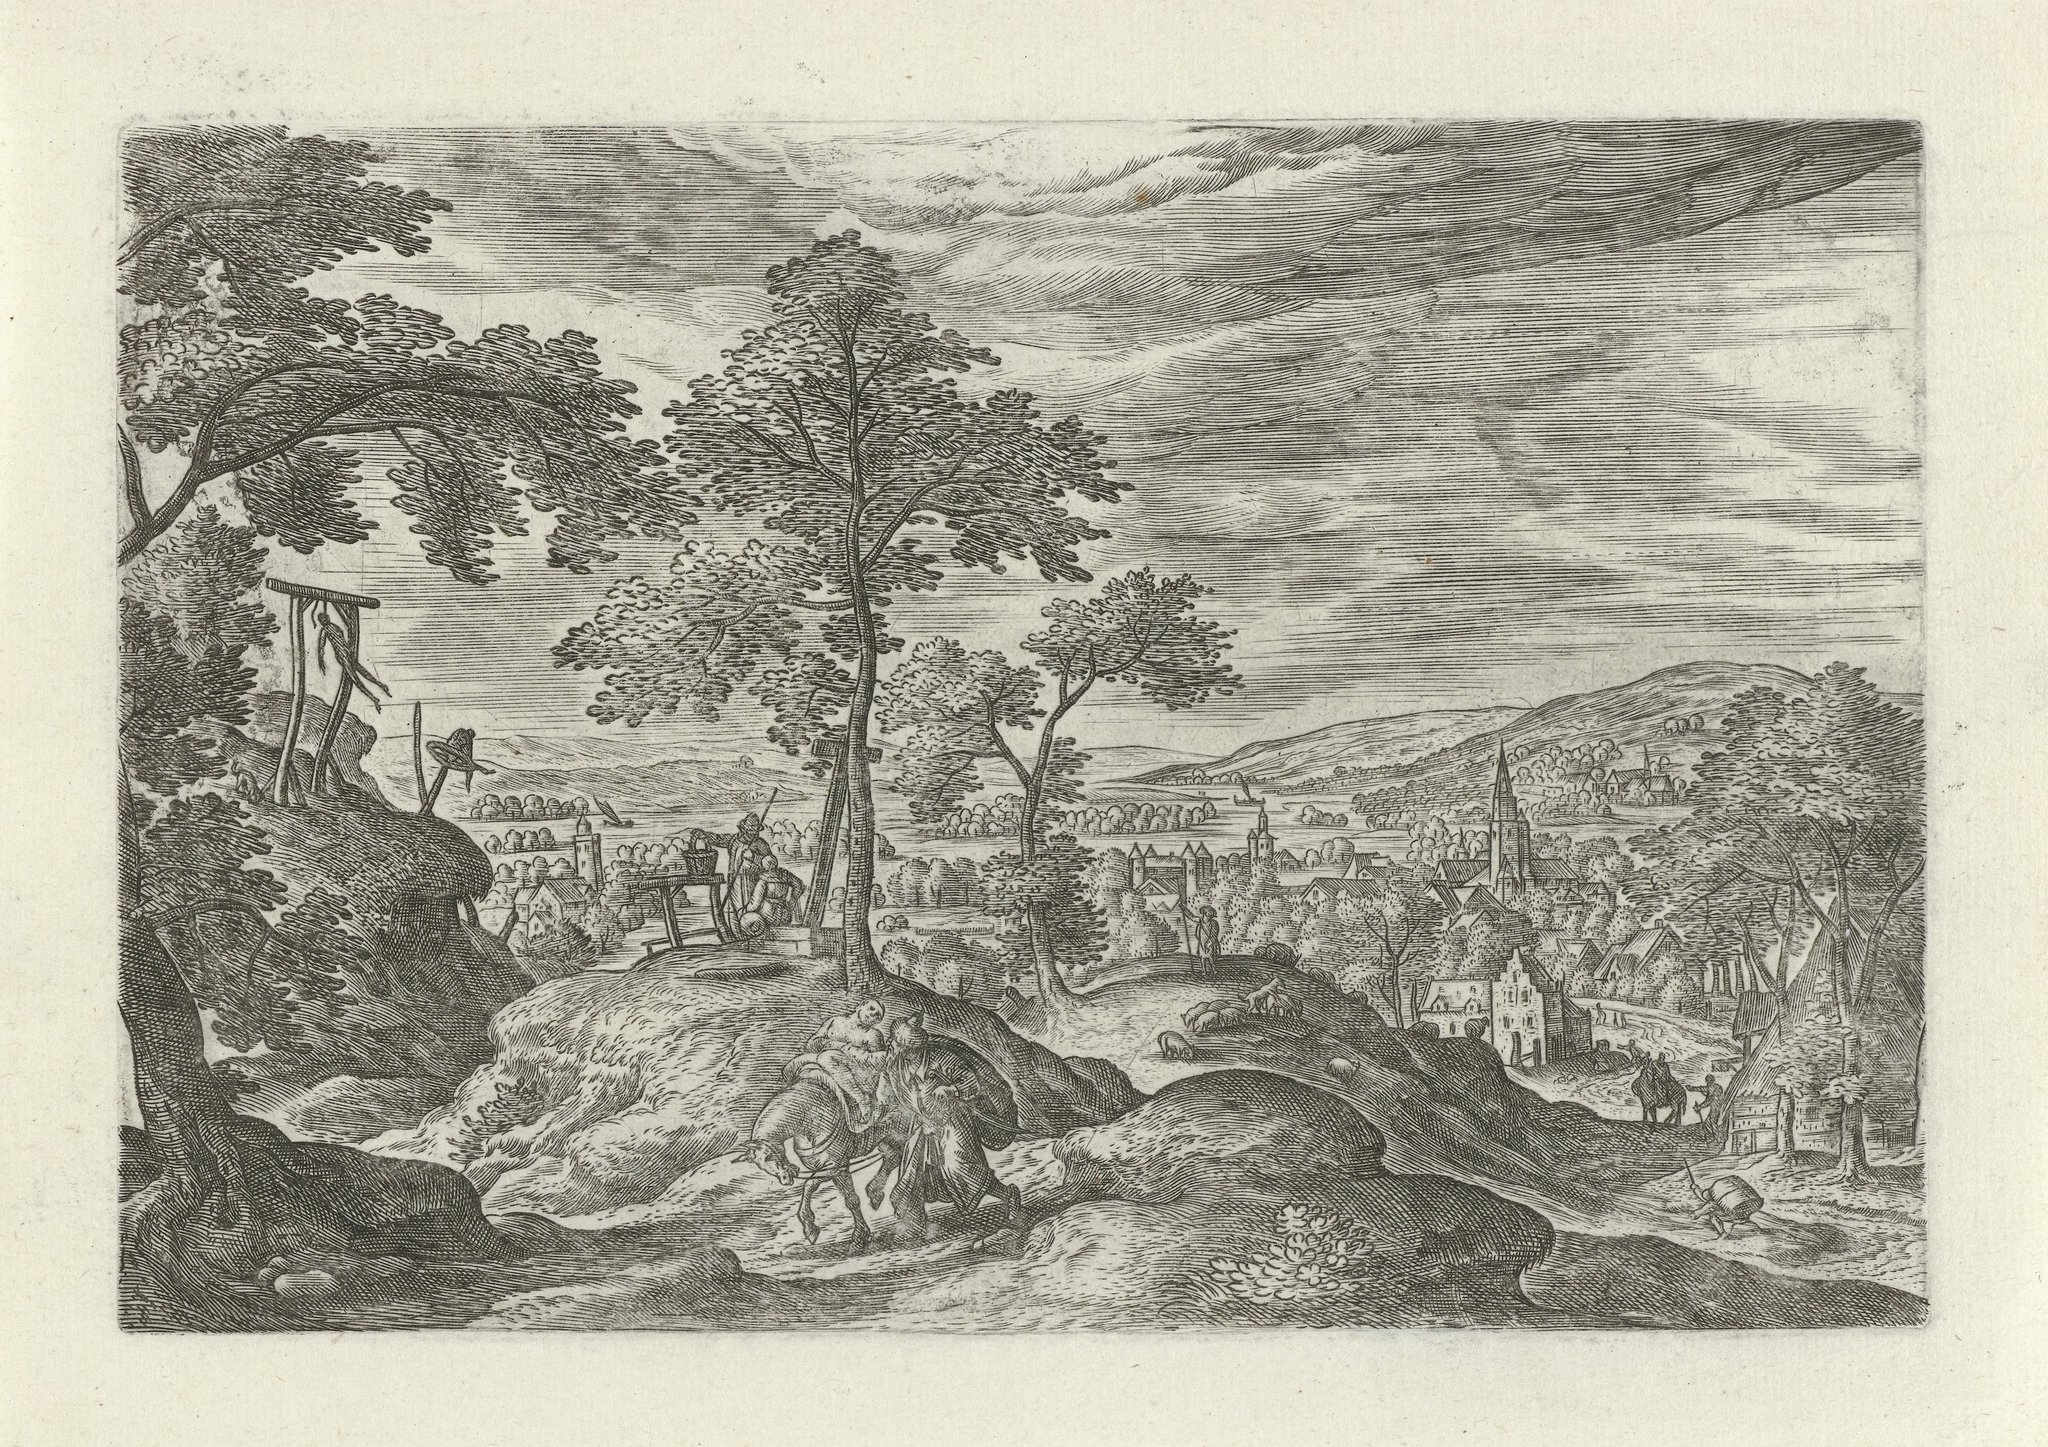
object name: print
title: Landschap met de barmhartige Samaritaan met op zijn paard de gewonde reiziger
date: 1560-1595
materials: paper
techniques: engraving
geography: antwerp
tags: the samaritan sets the wounded traveller on his mount (ass or horse), and brings him to an inn, on the scaffold or place of execution, forest, wood (+ landscape with figures, staffage), outskirts of village (+ city(-scape) with figures, staffage)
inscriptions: collector's mark: Lugt 2228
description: De barmharige Samaritaan brengt de gewonde reiziger naar een herberg op zijn paard. Op de achtergrond een heuvelachtig landschap met een stad en een galgenveld. De prent is deel van een vierdelige serie van landschappen met scènes uit de gelijkenis van de barmhartige Samaritaan